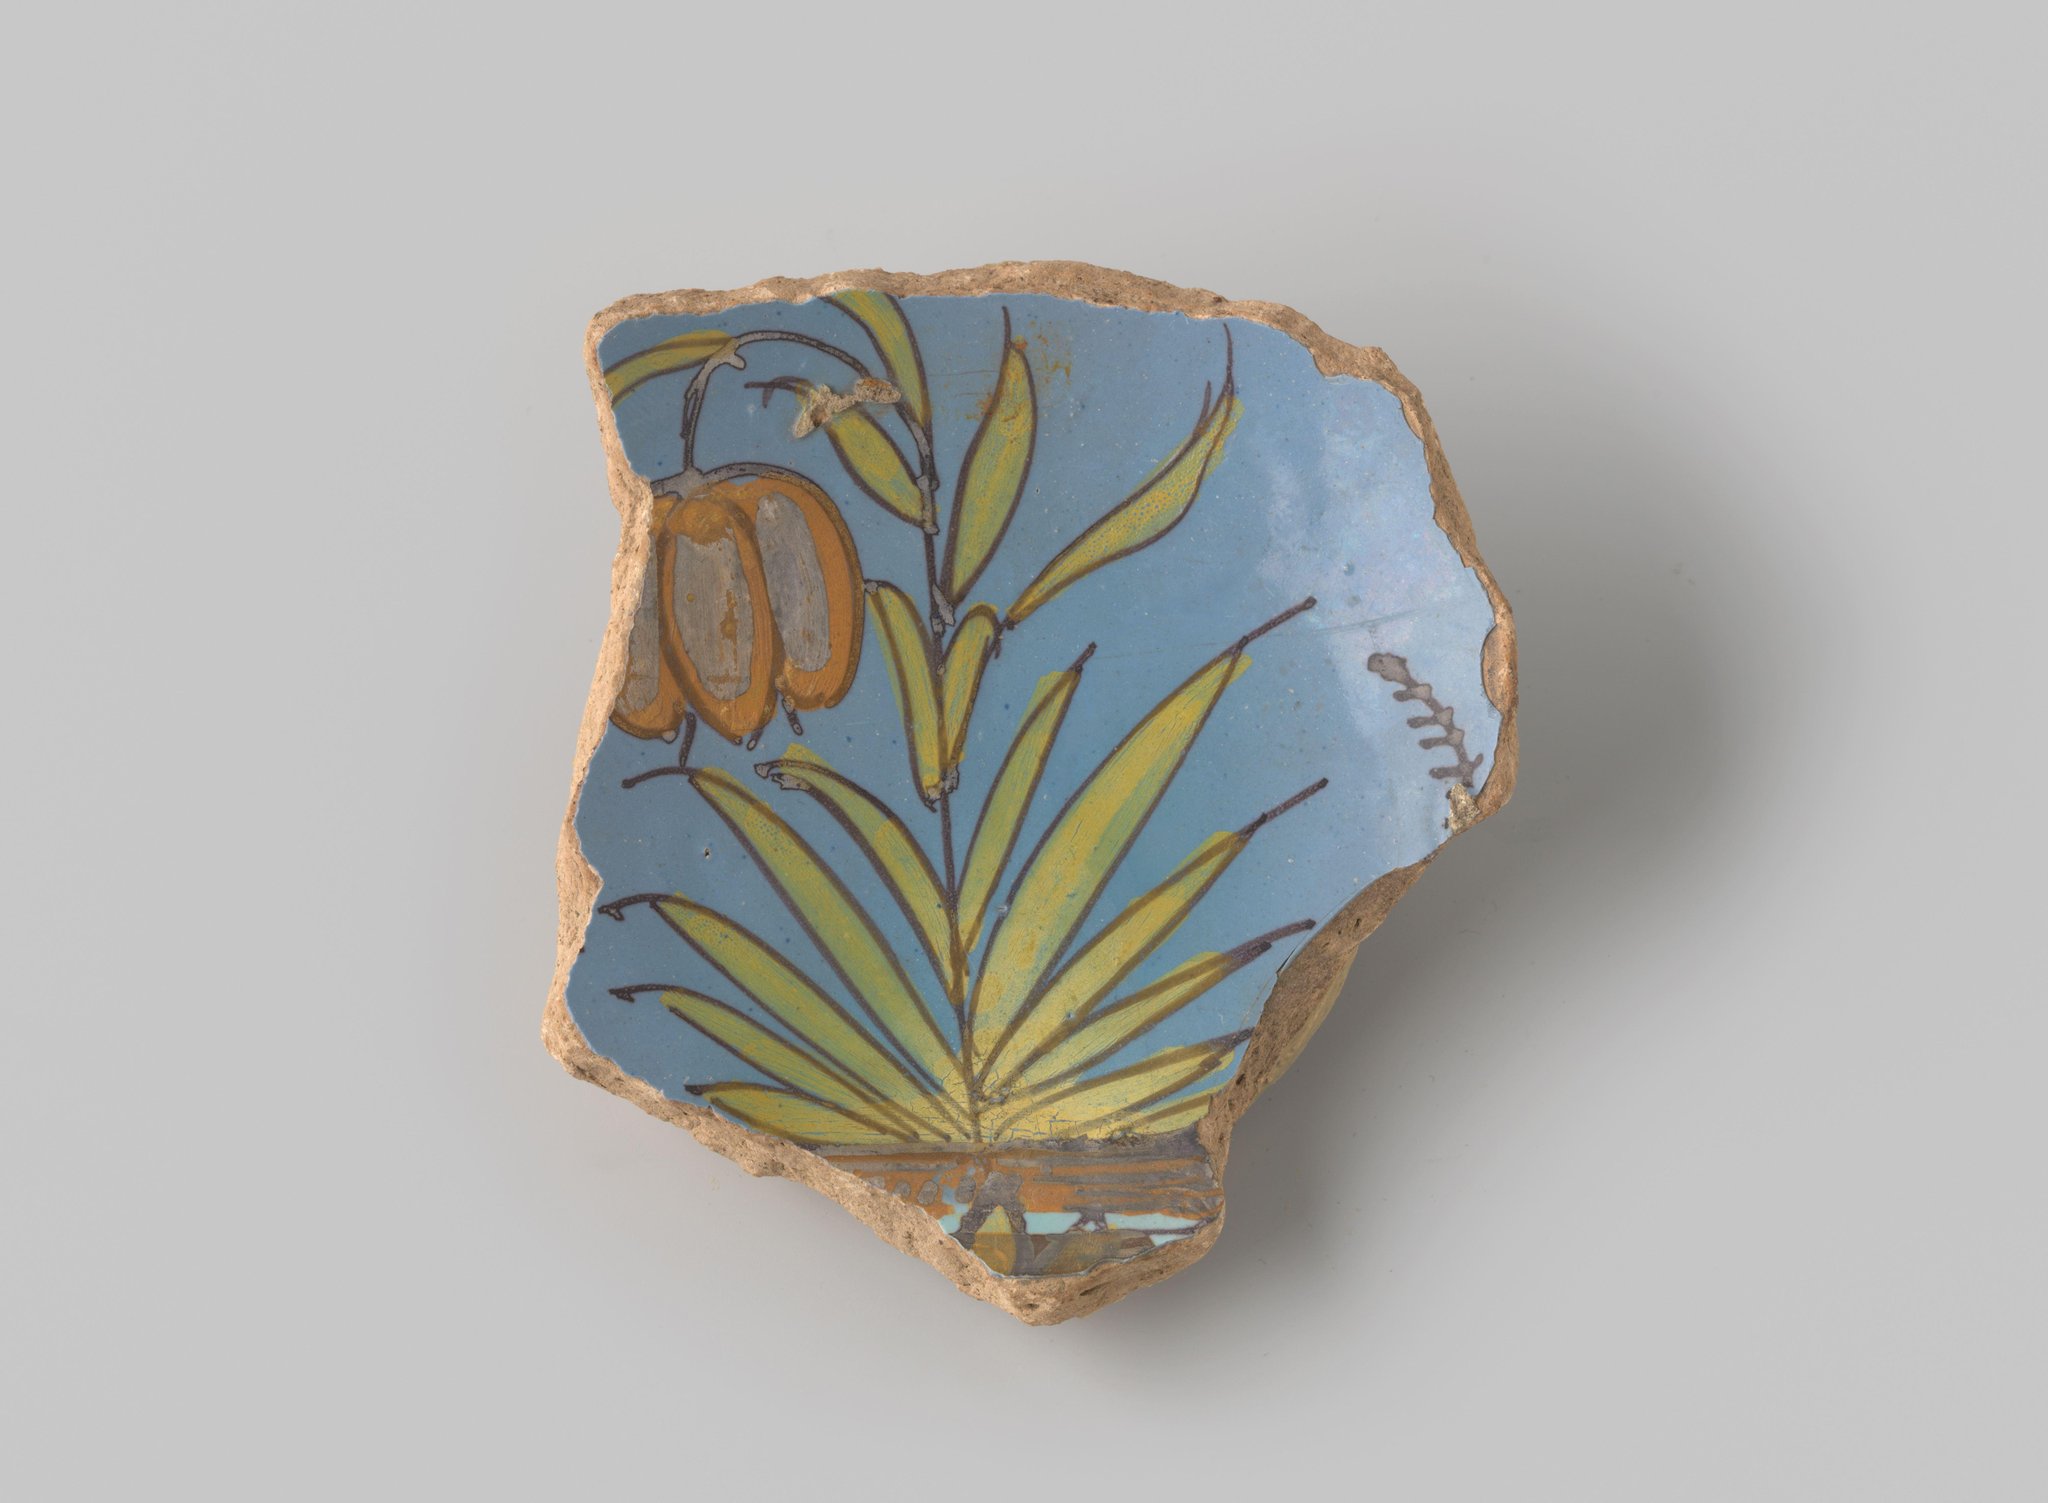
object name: sherd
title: Scherf van rossigbakkend aardewerk, aan de voorzijde voorzien van blauw glazuur, met daarop een schildering van een tulp die in de aarde staat, in bruin, groen, geel en oranje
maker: Anonymous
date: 1600-1650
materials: earthenware, glaze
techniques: maiolica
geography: northern netherlands